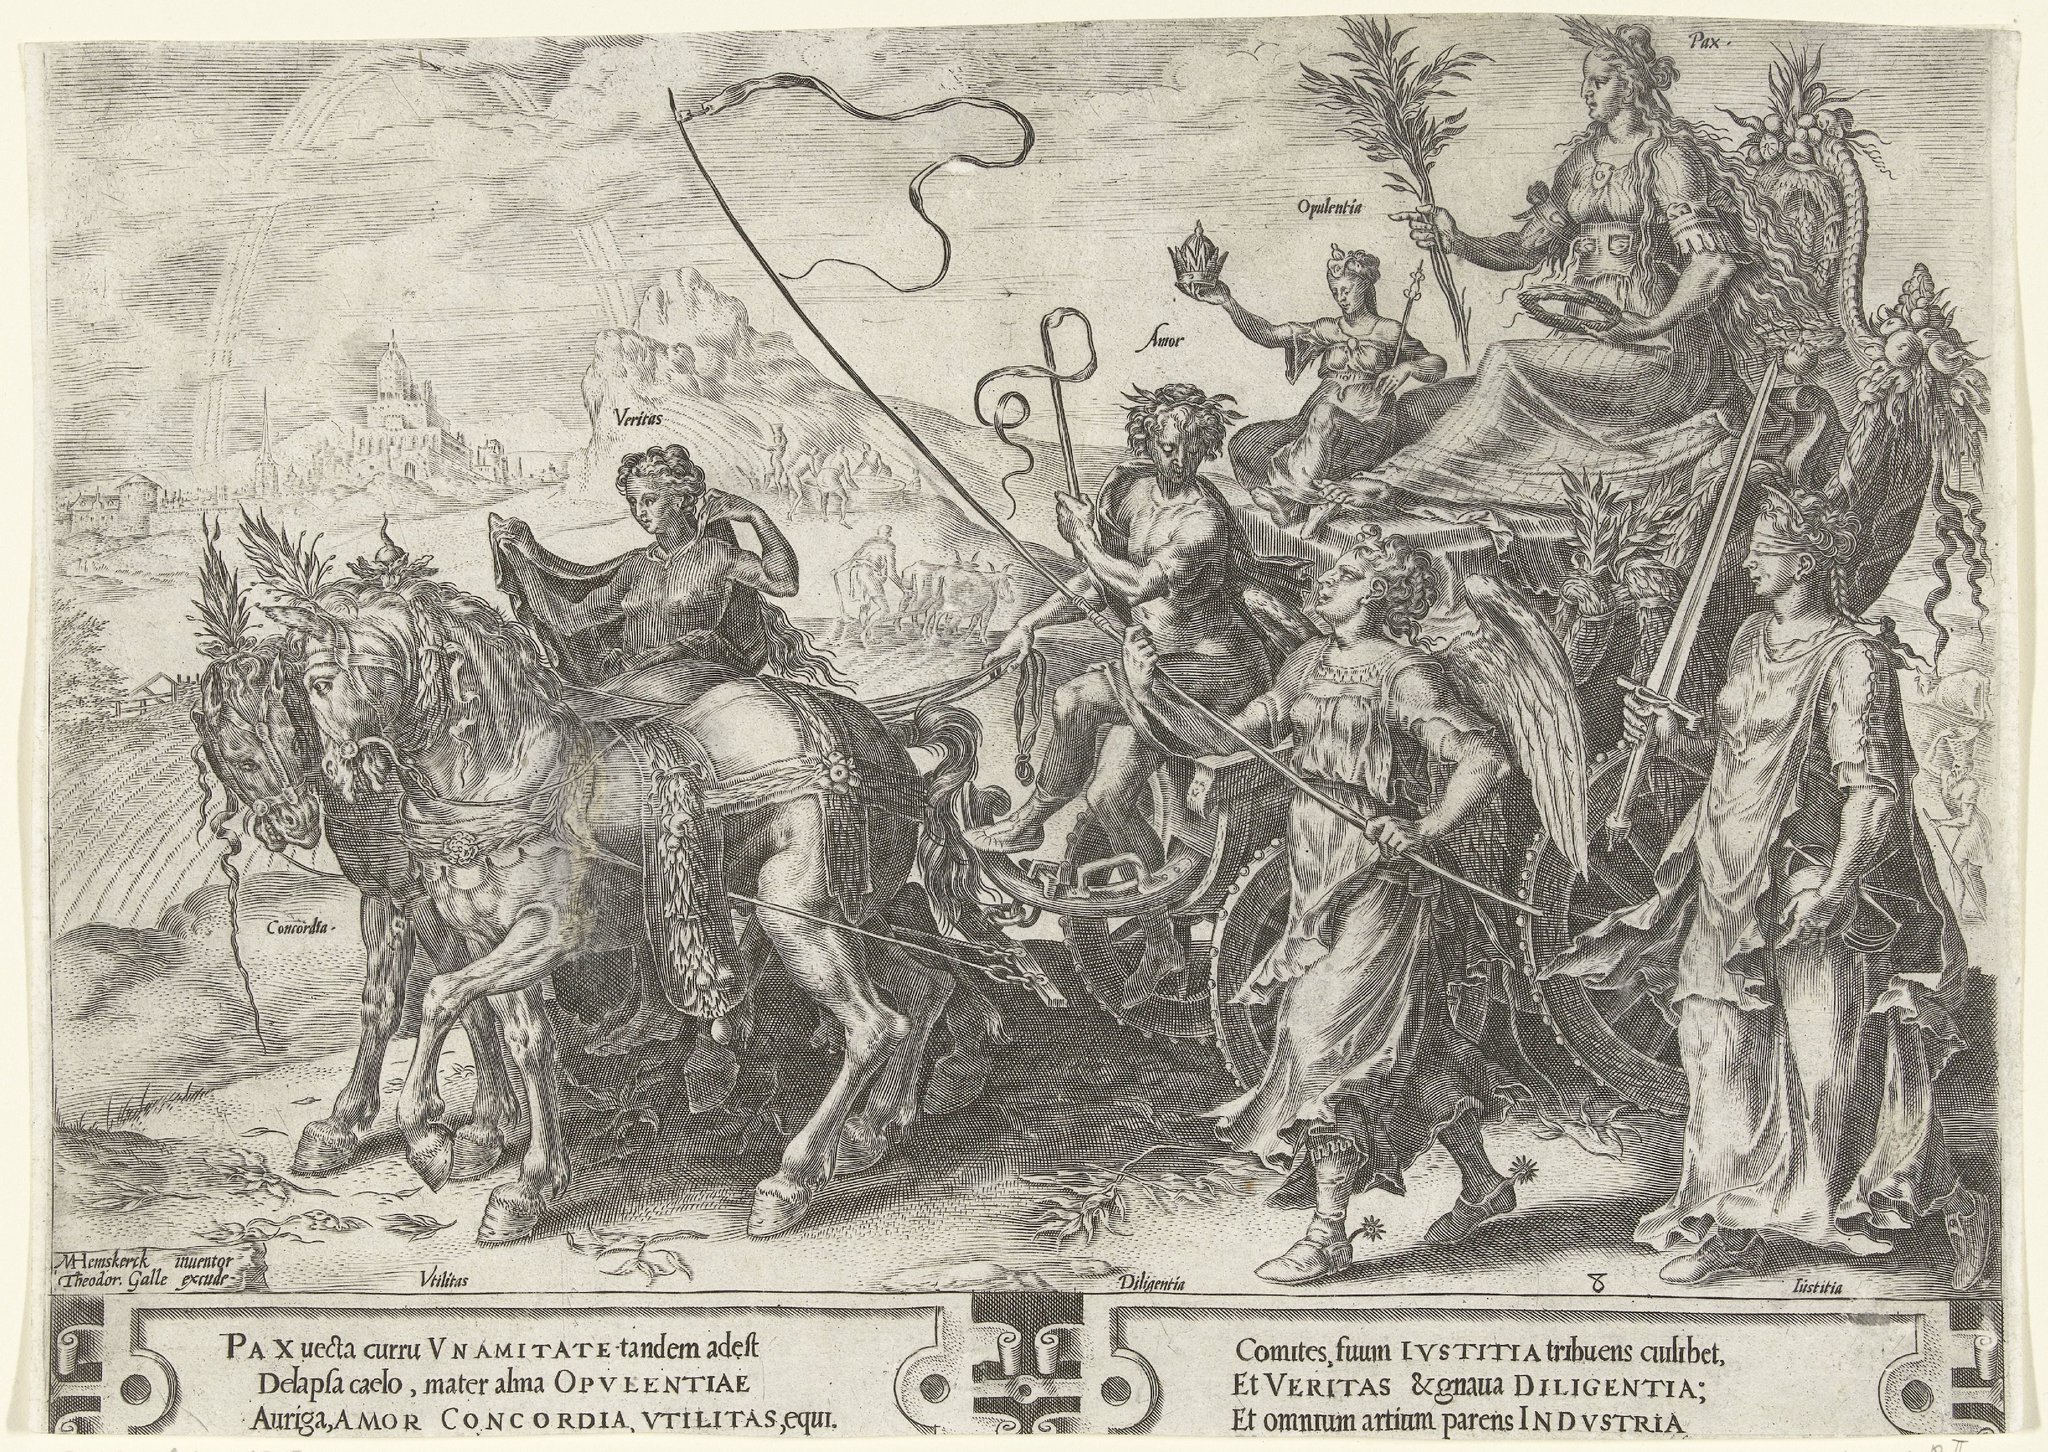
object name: print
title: Circulus Vicissitudinis Rerum Humanarum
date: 1564-1633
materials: paper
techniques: engraving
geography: antwerp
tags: truth; 'verità' (ripa) (+ allegorical scene, i.e. two or more personifications involved in an action), justice, 'justitia'; 'giustitia divina' (ripa) ~ one of the four cardinal virtues, vicissitudes of life (+ allegorical scene, i.e. two or more personifications involved in an action), symbols, allegories of peace, 'pax'; 'pace' (ripa), chariot, triumphal car, wealth, opulence; 'opulenza', 'richezza' (ripa), carefulness, diligence; 'diligenza' (ripa)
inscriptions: number: ‘8’, caption: ‘PAX curru UNANOMITATE tandem adest...parens INDUSTRIA’, collector's mark: Lugt 2760, collector's mark: Lugt 2228, signature: ‘MHemskerck inventor’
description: Triomfwagen versierd met guirlandes van vruchten, getrokken door twee paarden (Concordia en Utilitas). De wagen wordt gemend door Amor. Op een zetel zit de Vrede, olijftakken in de rechterhand en op het hoofd, lauwerkrans in de linkerhand. Rechts van haar zit Rijkdom (Opulentia) die een kroon ophoudt. Naast de wagen lopen Waarheid, Vlijt en Rechtvaardigheid (Veritas, Diligentia en Justitia). Prent uit een serie van negen prenten met triomfwagens uit de Antwerpse Besnijdenis-ommegang van 1561. De personificaties op de wagens verbeelden samen de kringloop van het menselijk handelen.